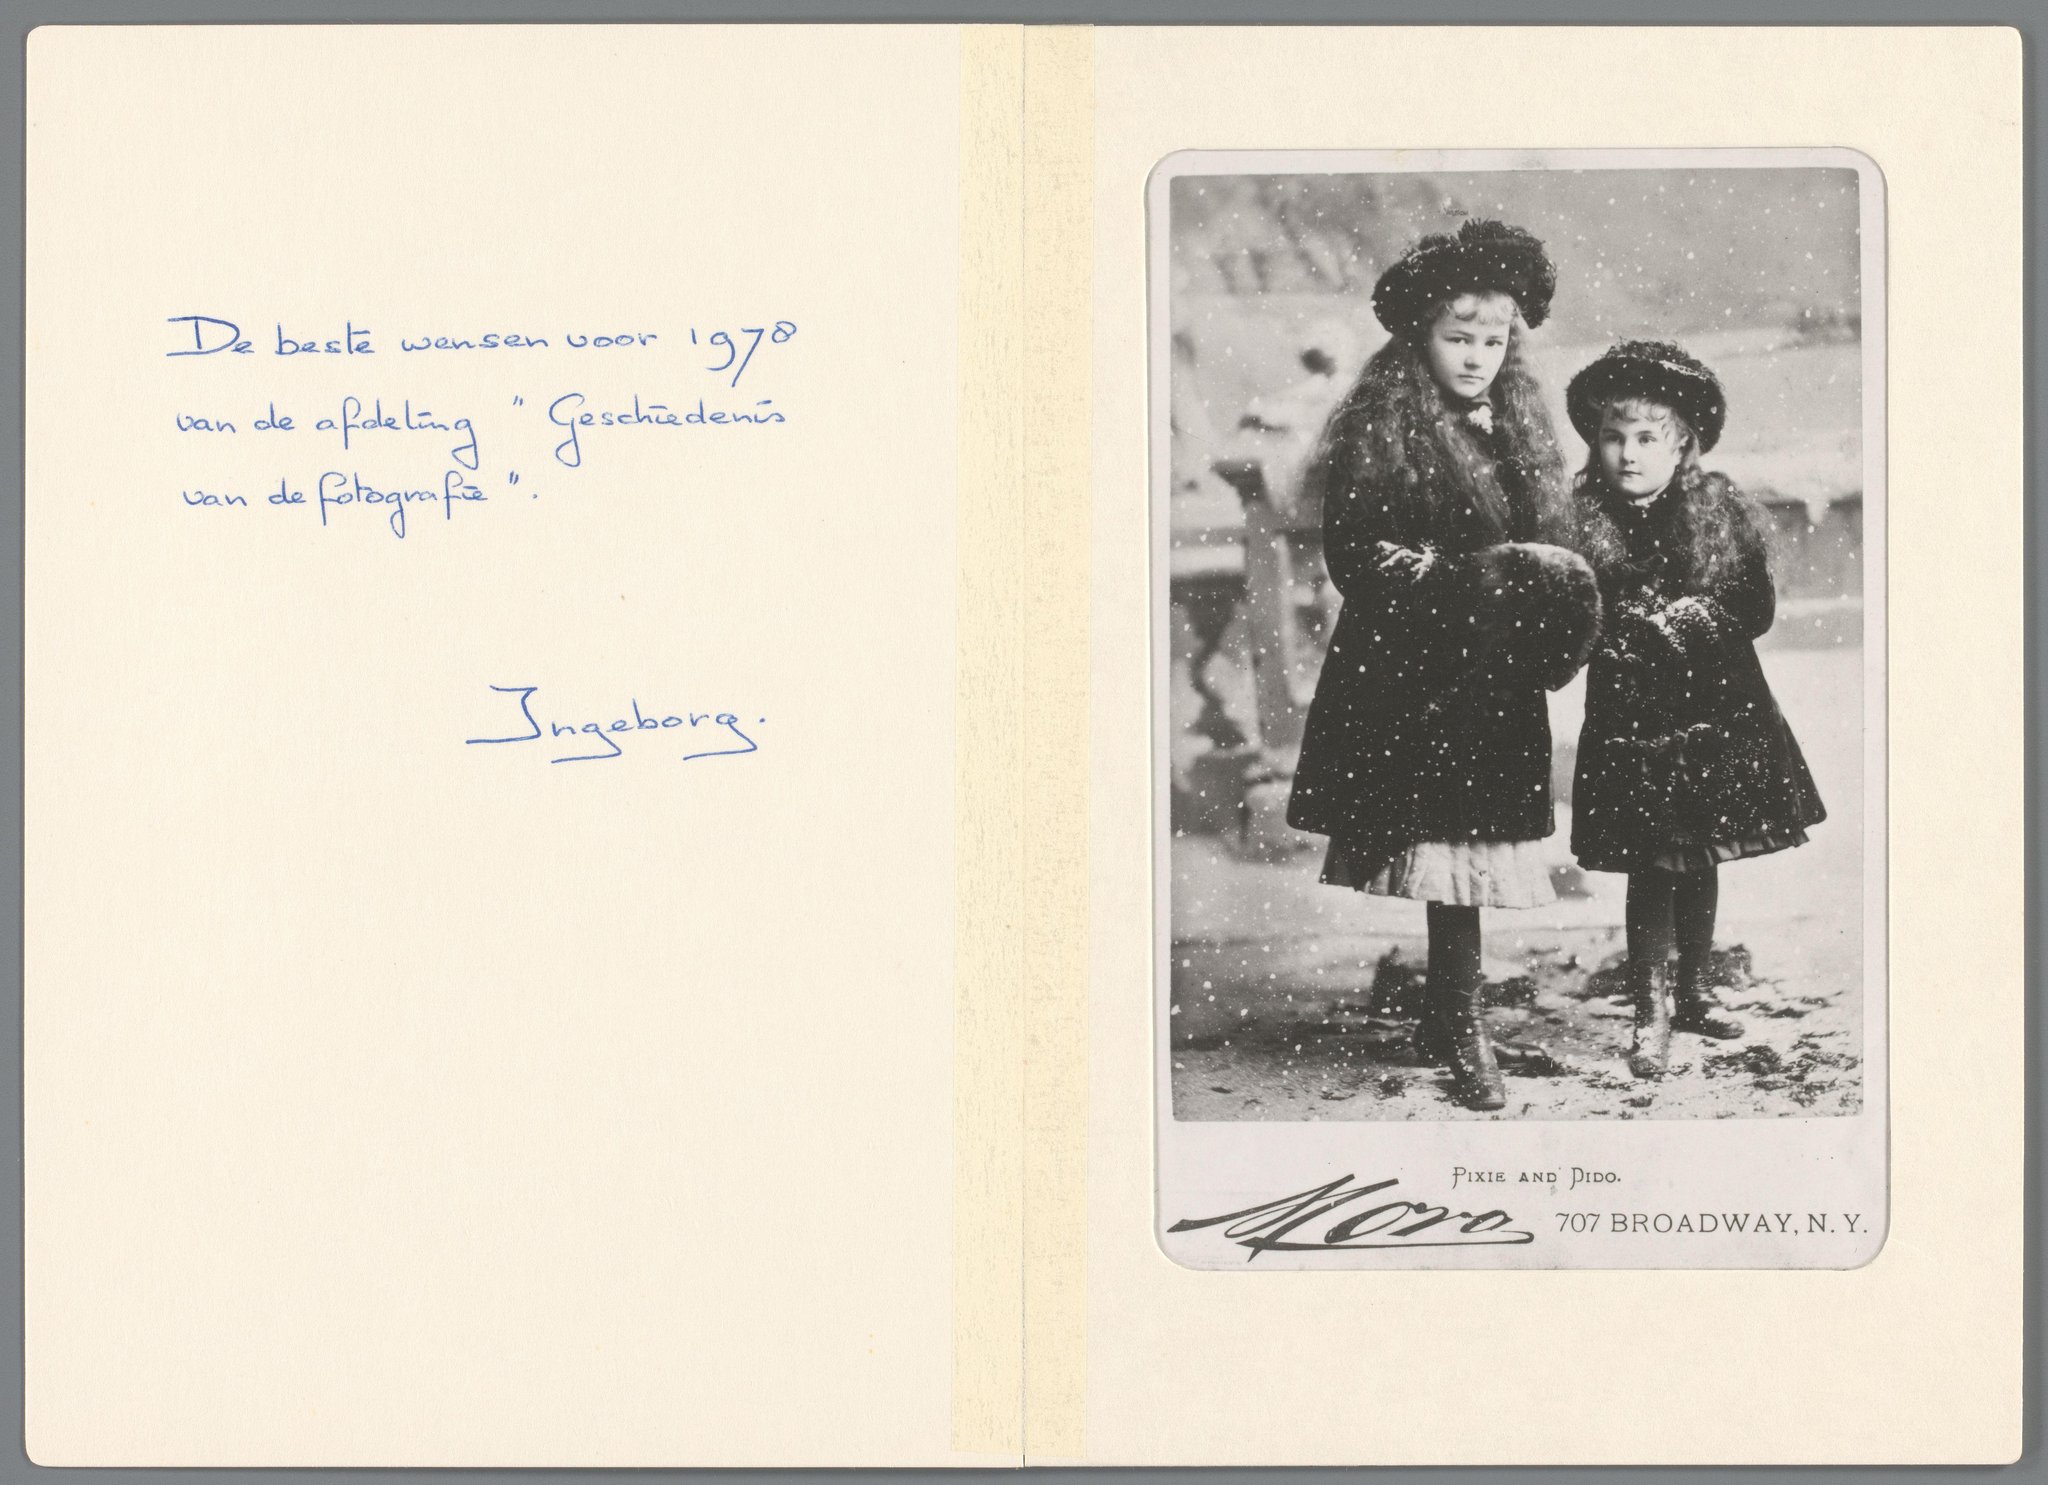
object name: new year card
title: Nieuwjaarswens voor 1978 met fotoreproductie van een portret van Pixie en Dido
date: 1977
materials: paper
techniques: gelatin silver print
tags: l.j. hartkamp, portrait of actor, actress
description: Nieuwjaarswens van de afdeling Geschiedenis van de fotografie, van het prentenkabinet Leiden, ondertekend door Ingeborg Leijerzapf, gericht aan Bert Hartkamp.